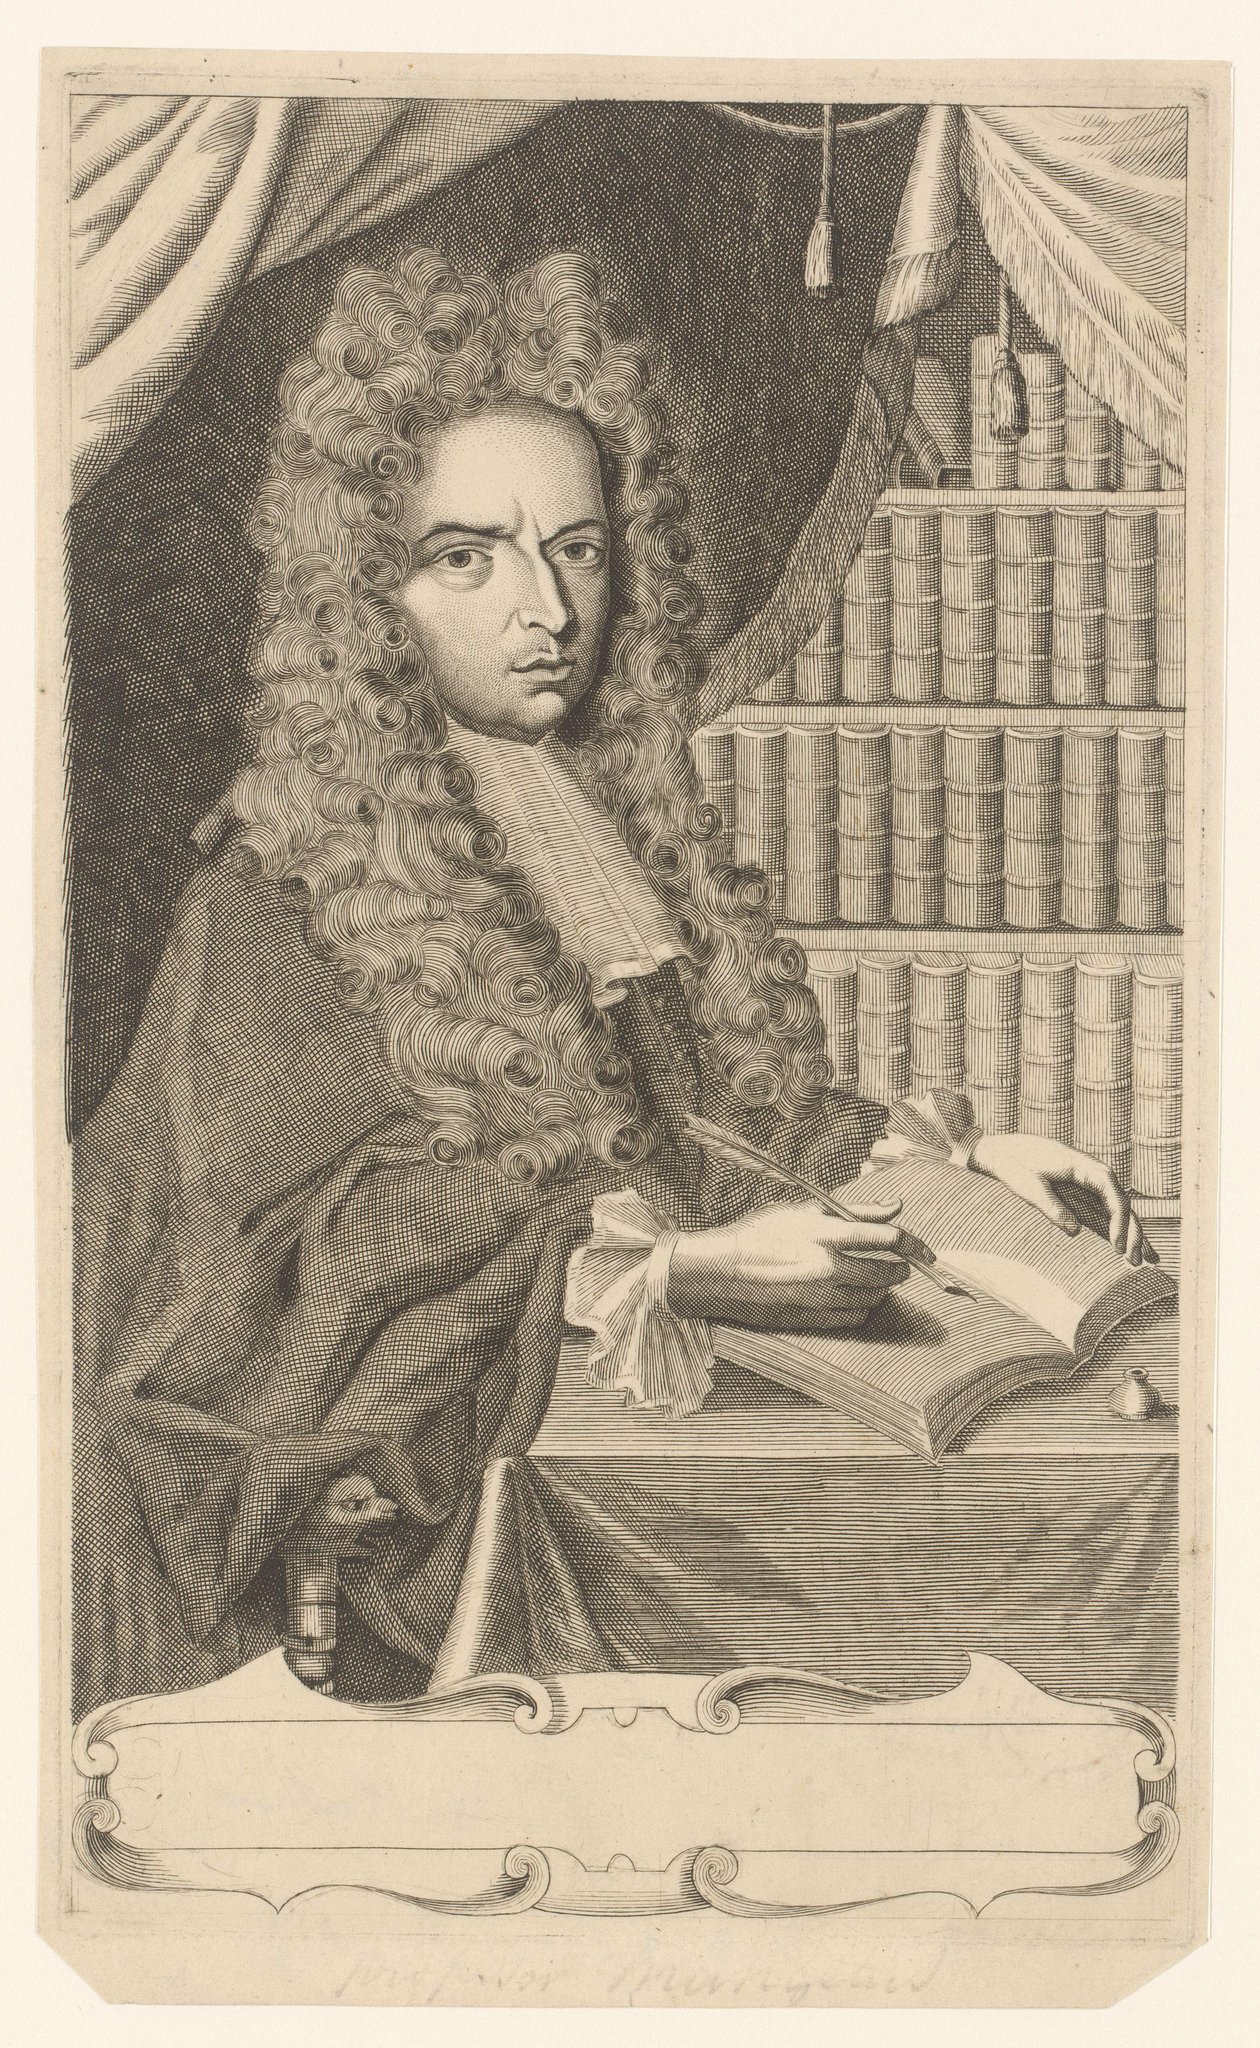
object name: print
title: Portret van een onbekende man, schrijvend in een boek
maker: Anonymous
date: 1700-1799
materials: paper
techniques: engraving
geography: germany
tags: historical persons not known by name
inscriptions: collector's mark: Lugt 240, inscription: ‘Mulles(?) : Wilhelm v. Bel[...]’, inscription: ‘professor Mangelus (?)’, inscription: ‘W: Planten (?) of W: Hauten (?)’